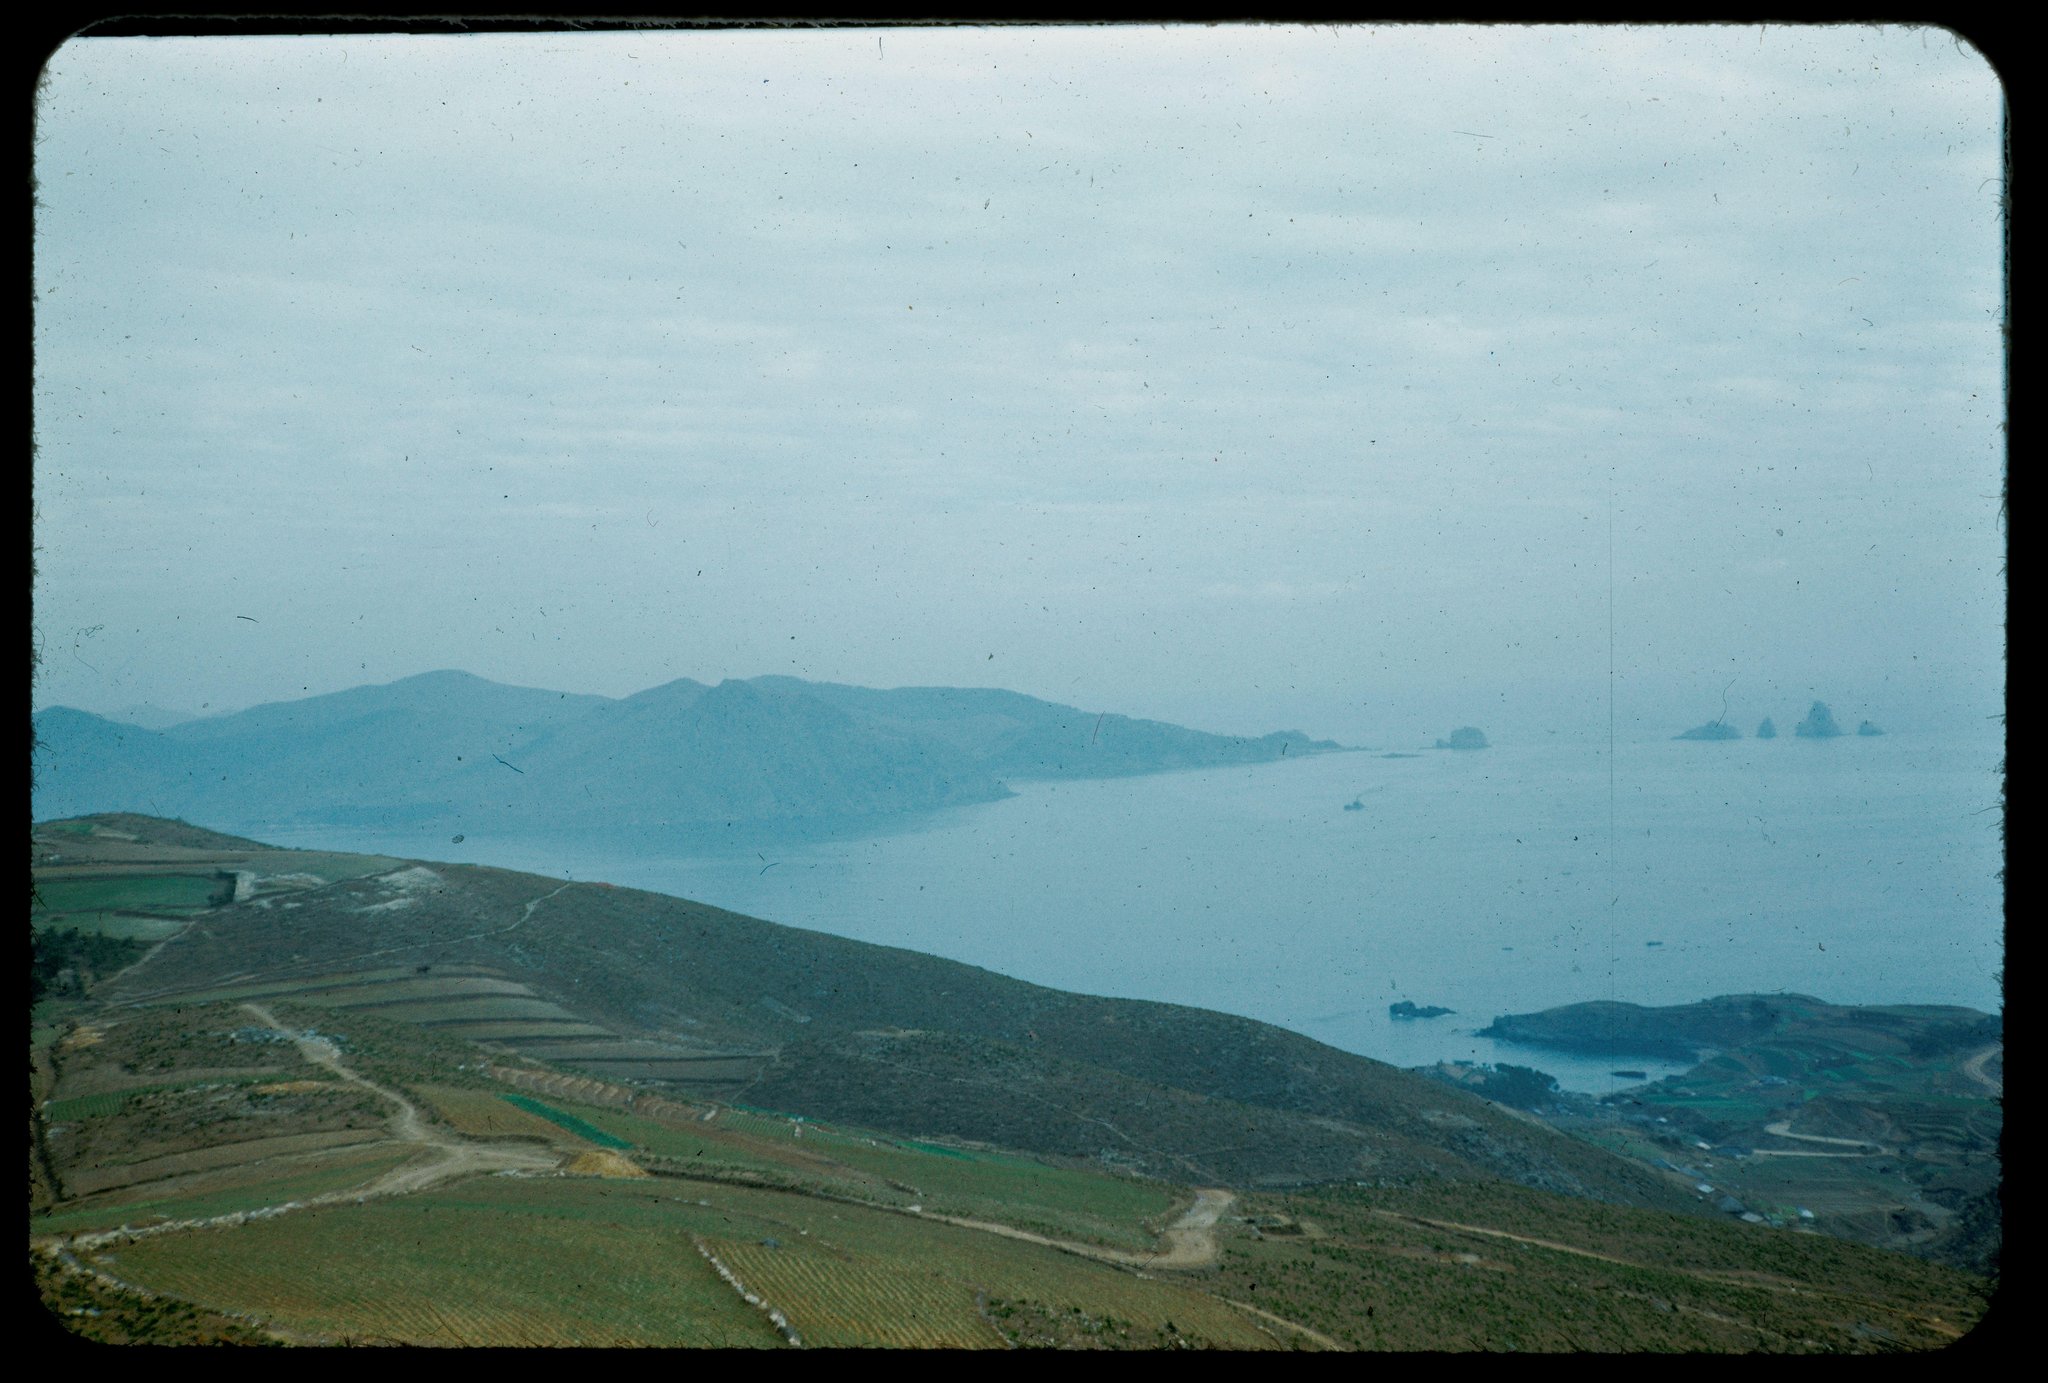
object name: color slide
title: Oorlog in Korea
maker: david ketel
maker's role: diplomaat, sinoloog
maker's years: 1913-2008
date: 1952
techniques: slide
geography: korea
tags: united nations